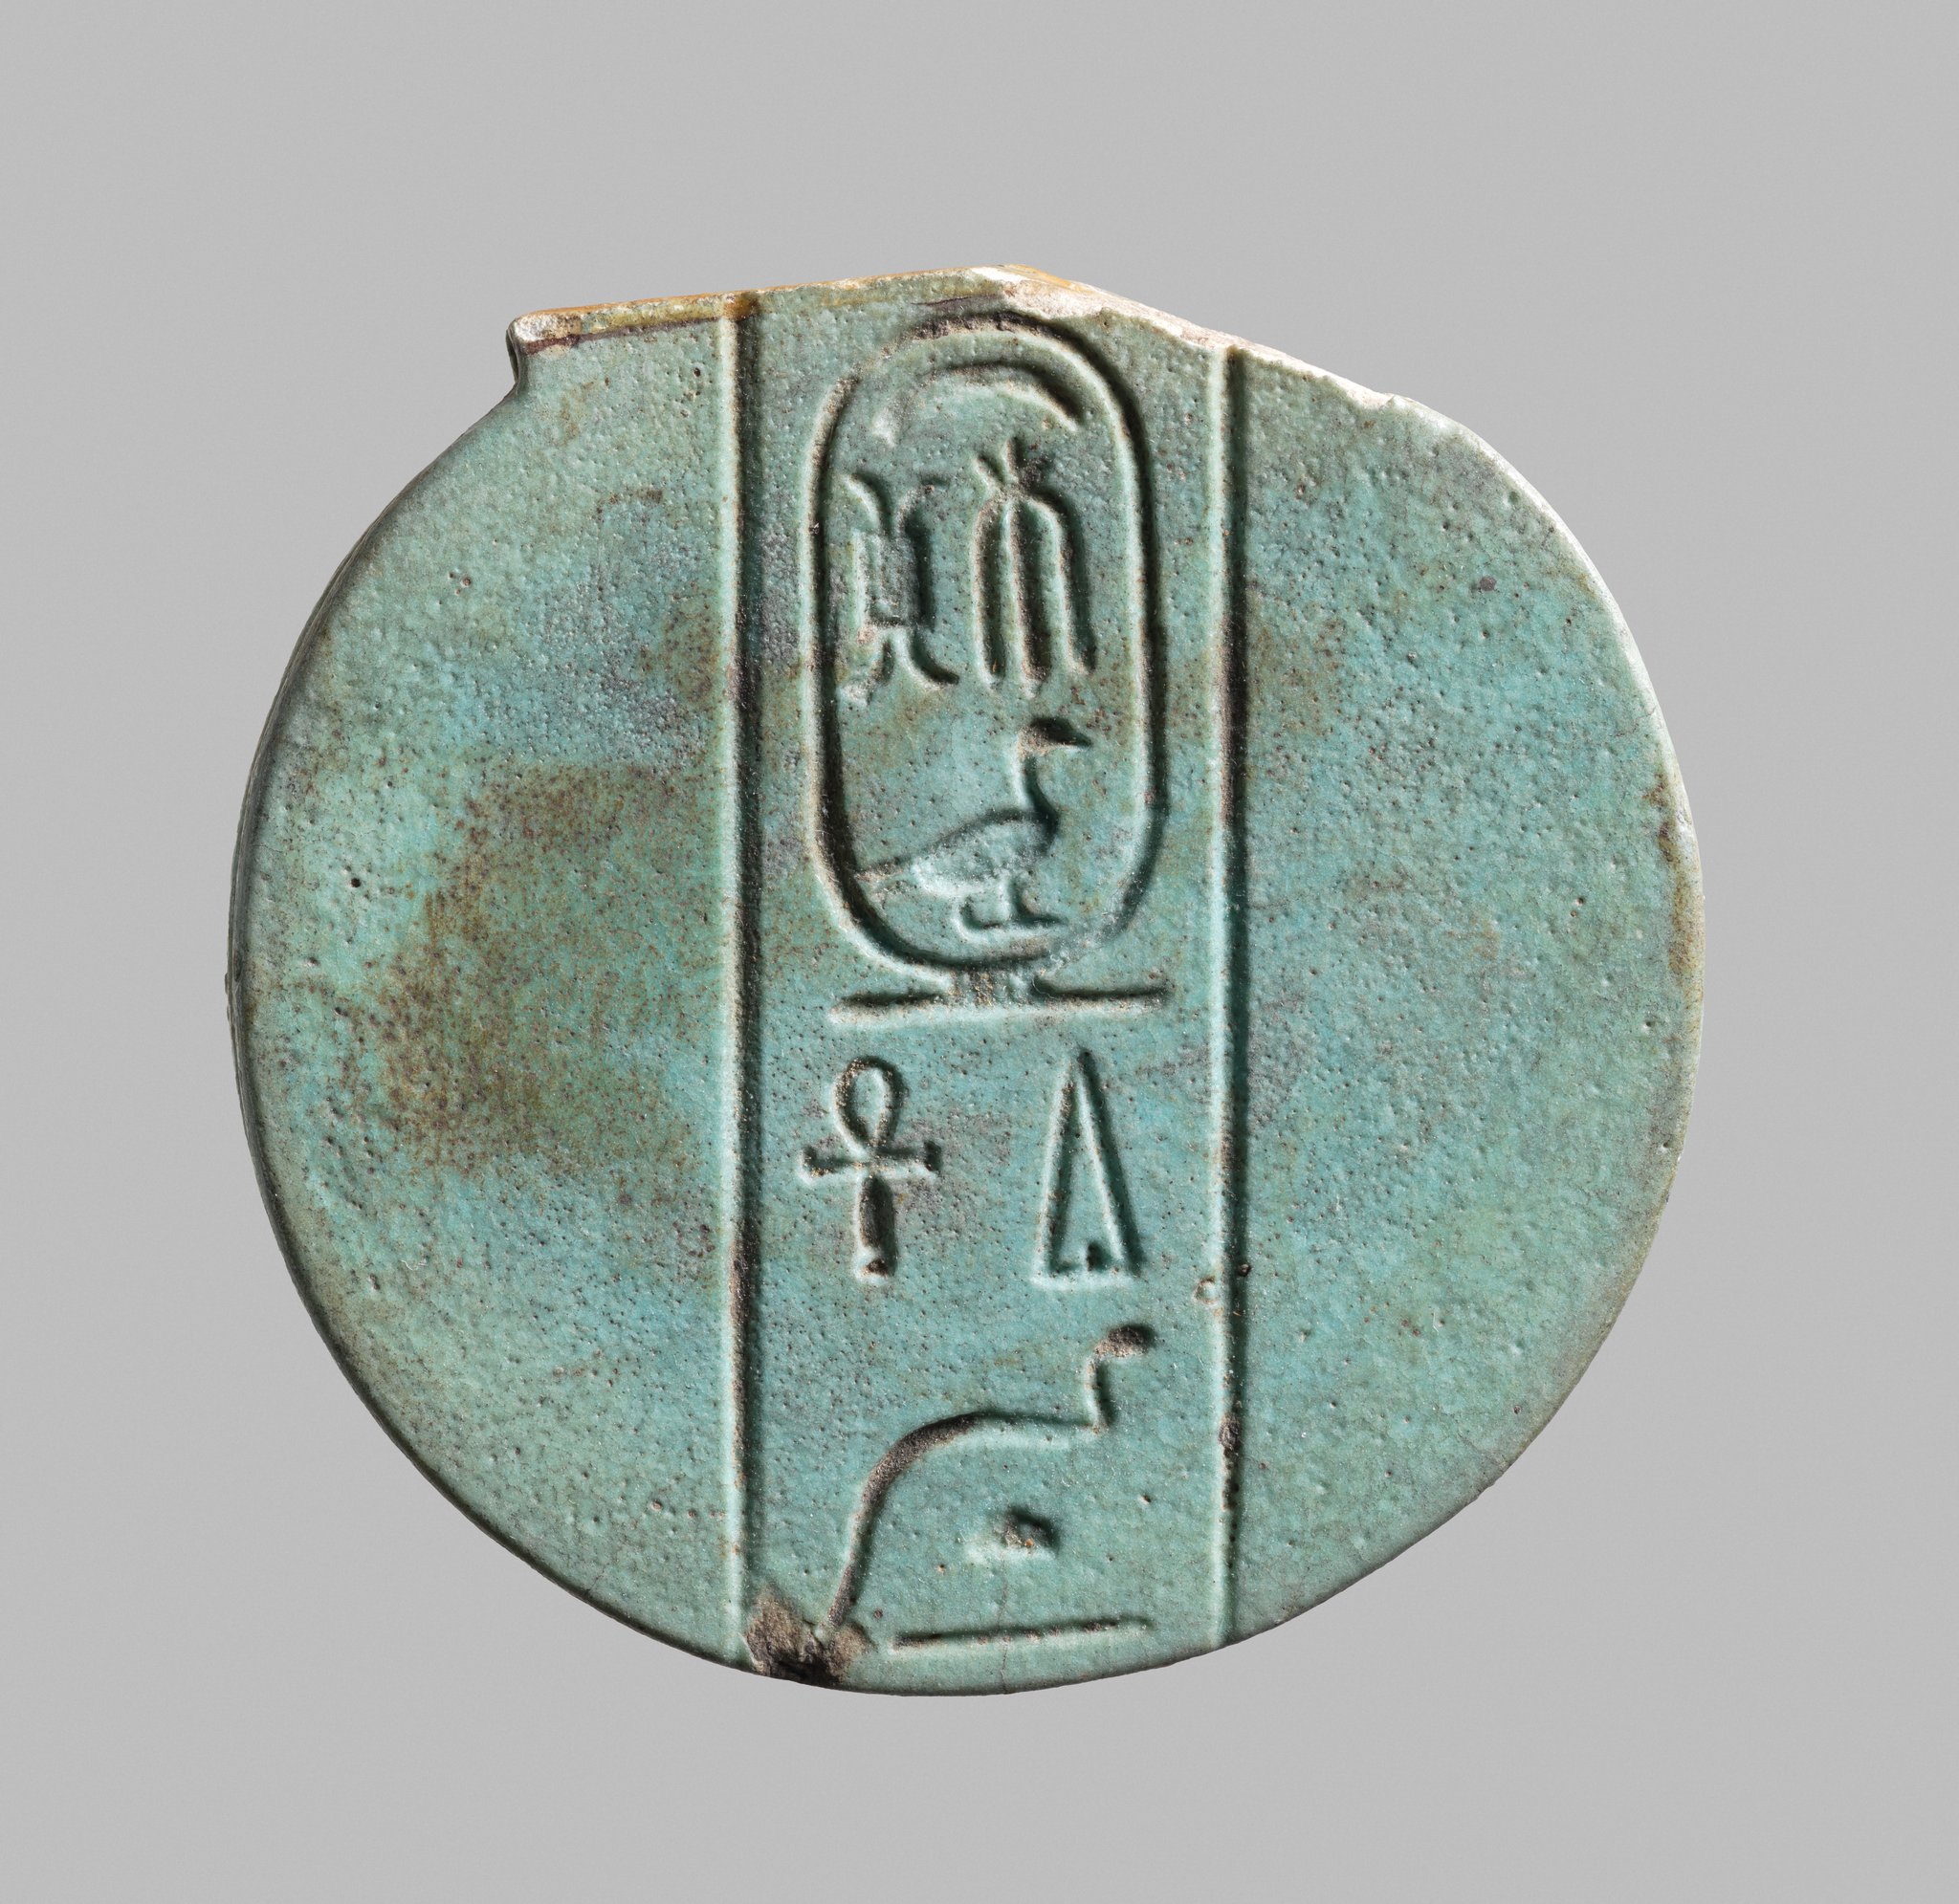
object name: menat counterpoise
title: Menat Counterpoise, Amasis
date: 570-526 BCE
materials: faience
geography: egypt